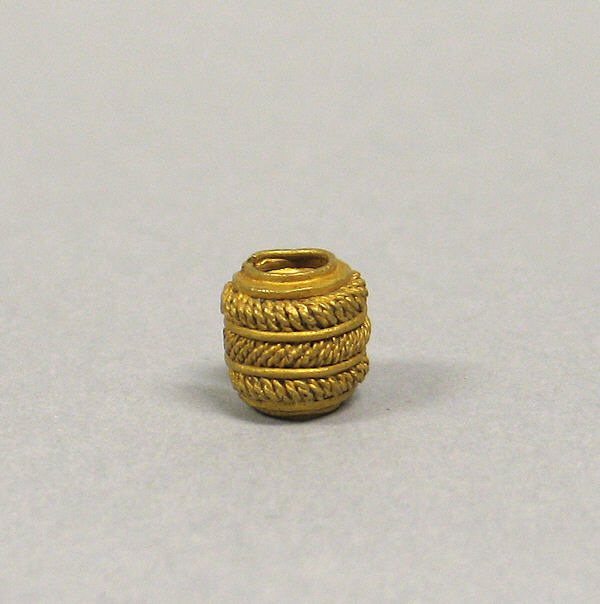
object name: ear ornament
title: Ear Ornament, Cylinder Hoops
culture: indonesian, central java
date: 701-1200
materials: gold